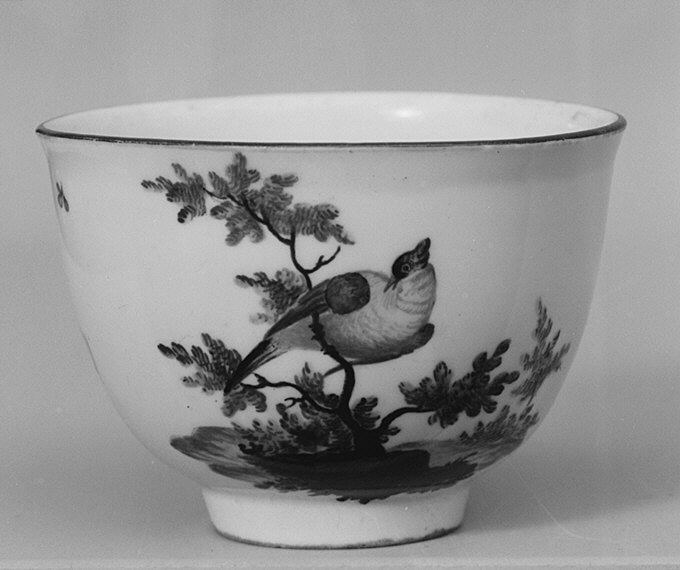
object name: cup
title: Cup (part of a service)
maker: frankenthal porcelain manufactory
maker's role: manufactory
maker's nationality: german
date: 1770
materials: hard paste porcelain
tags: birds,trees